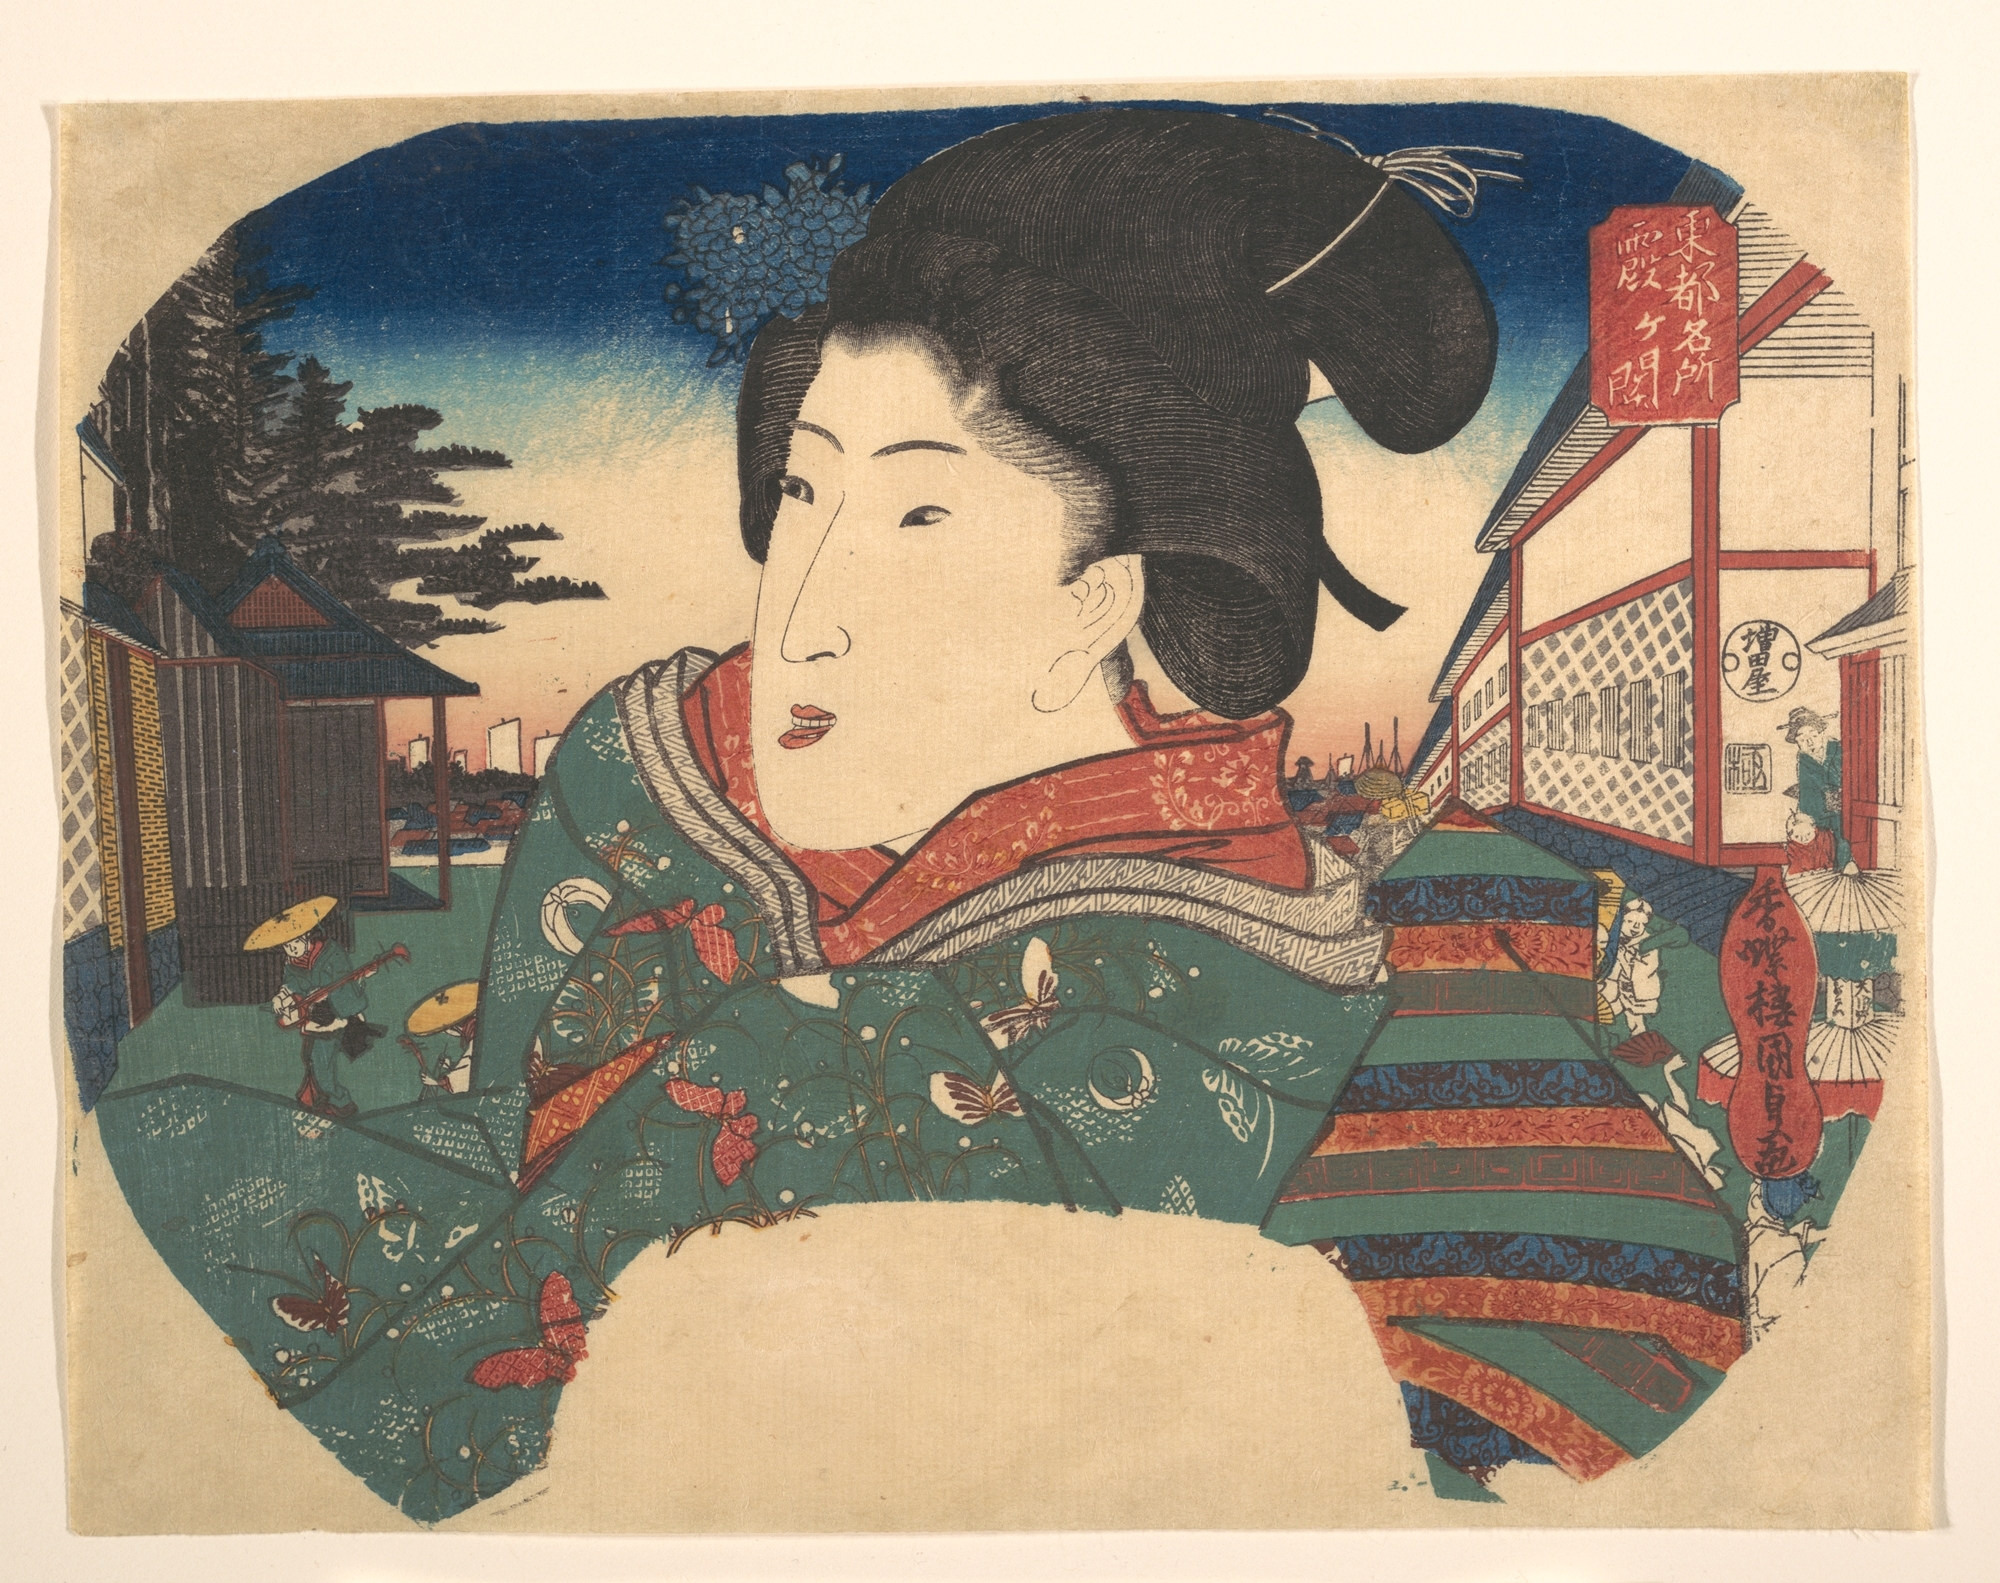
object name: print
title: Famous Views of Edo: Kasumigaseki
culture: japanese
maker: utagawa kunisada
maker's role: artist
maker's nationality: japanese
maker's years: 1786-1864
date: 1801-1900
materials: ink, paper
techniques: woodblock print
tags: portraits,women